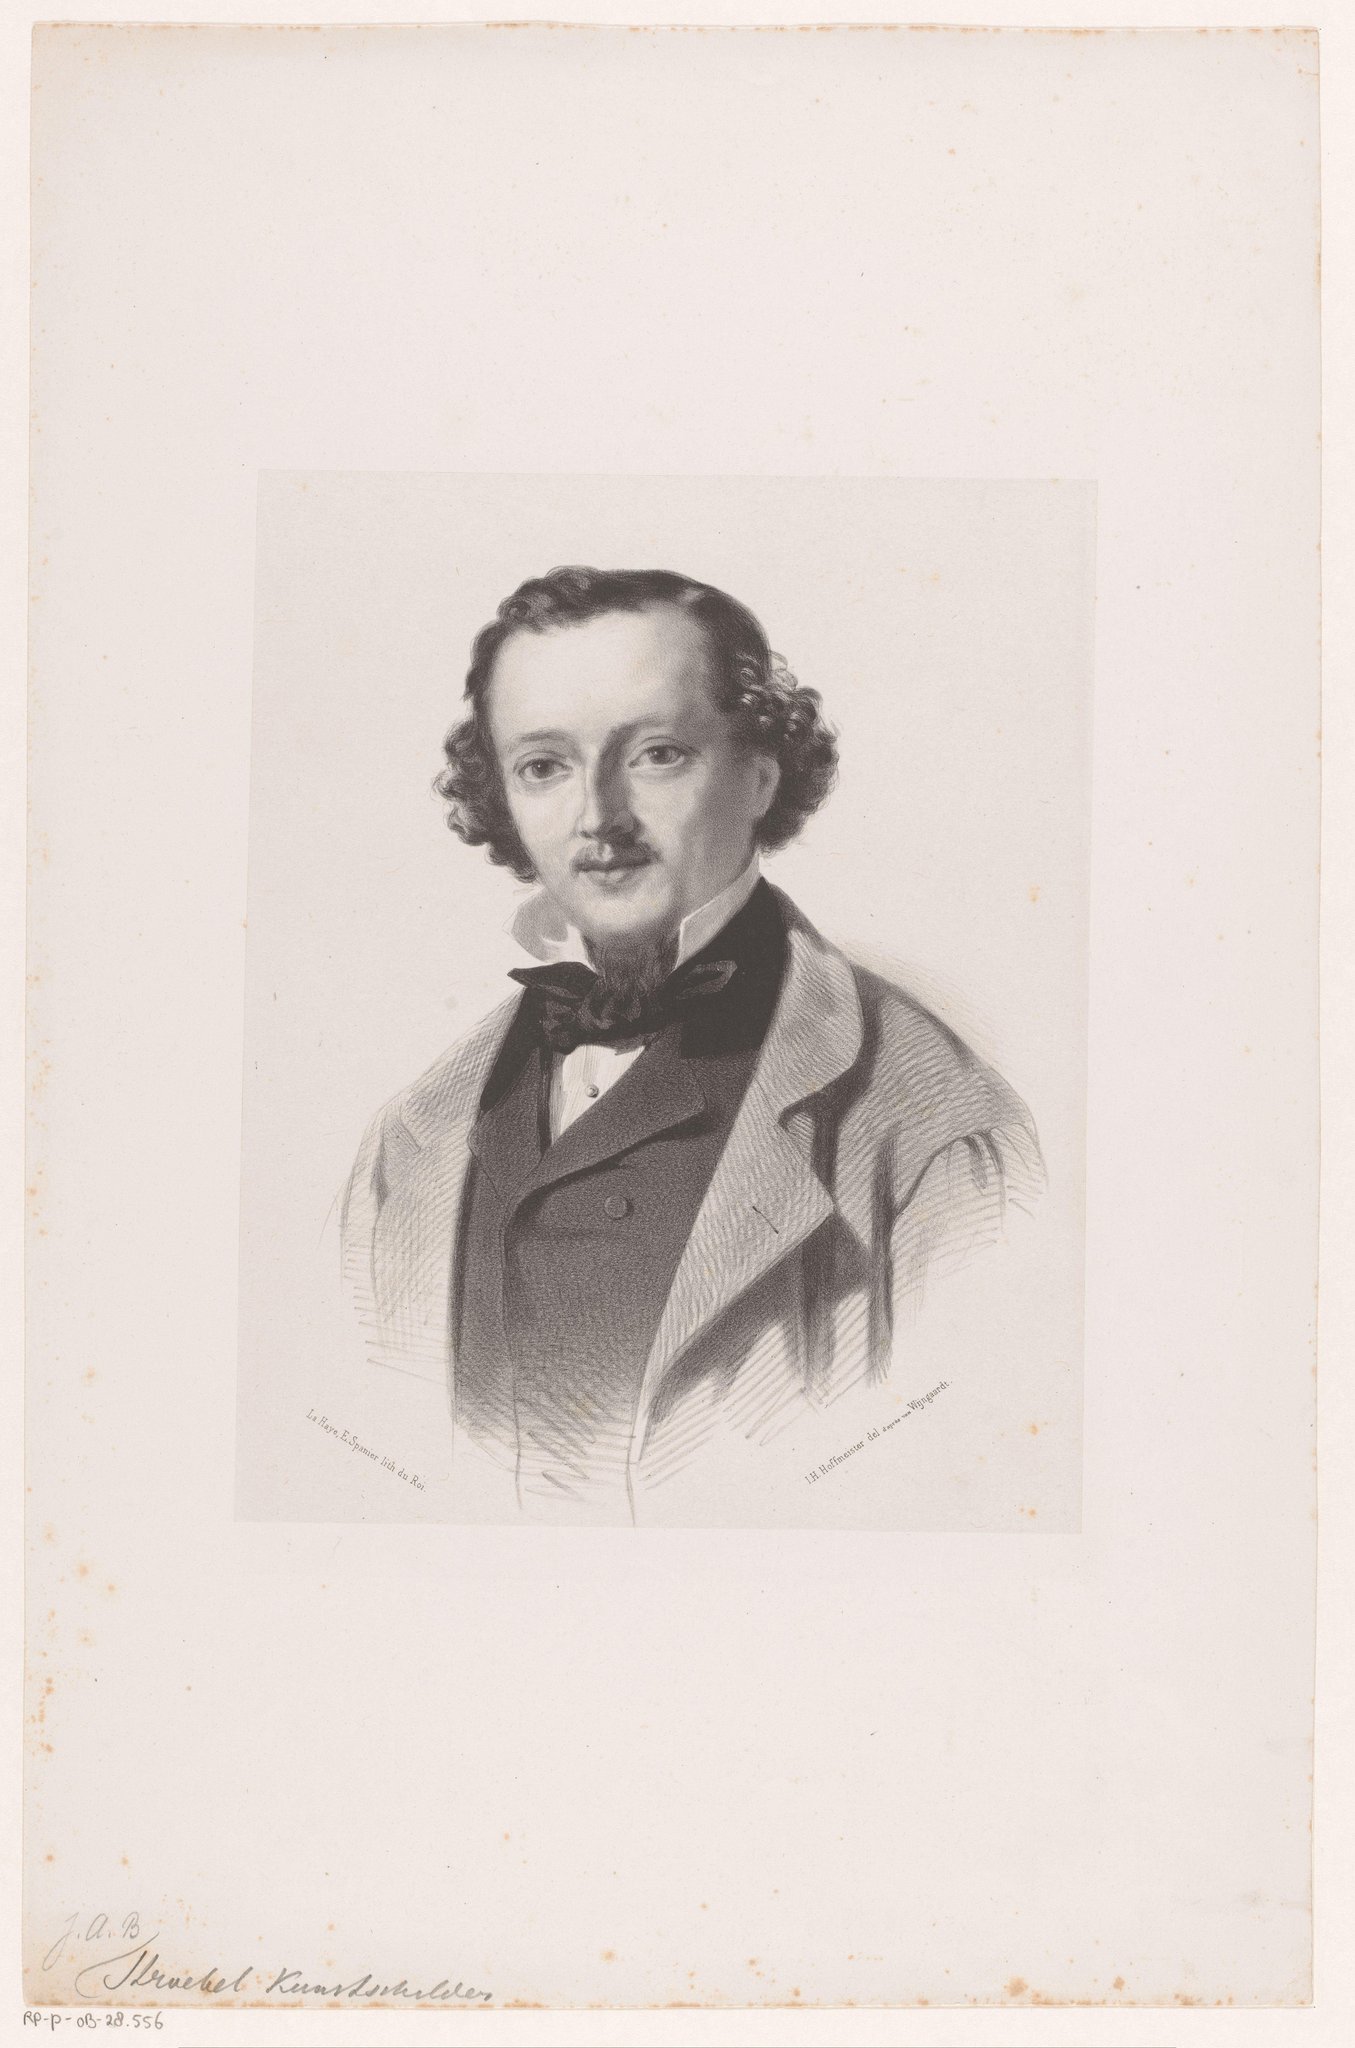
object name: print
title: Portret van Johannes Stroebel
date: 1851-1883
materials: paper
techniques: lithograph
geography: netherlands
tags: the hague, leiden, painter, print maker, draughtsman, johannes stroebel, historical persons (+ (full) bust portrait)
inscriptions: collector's mark: Lugt 2228